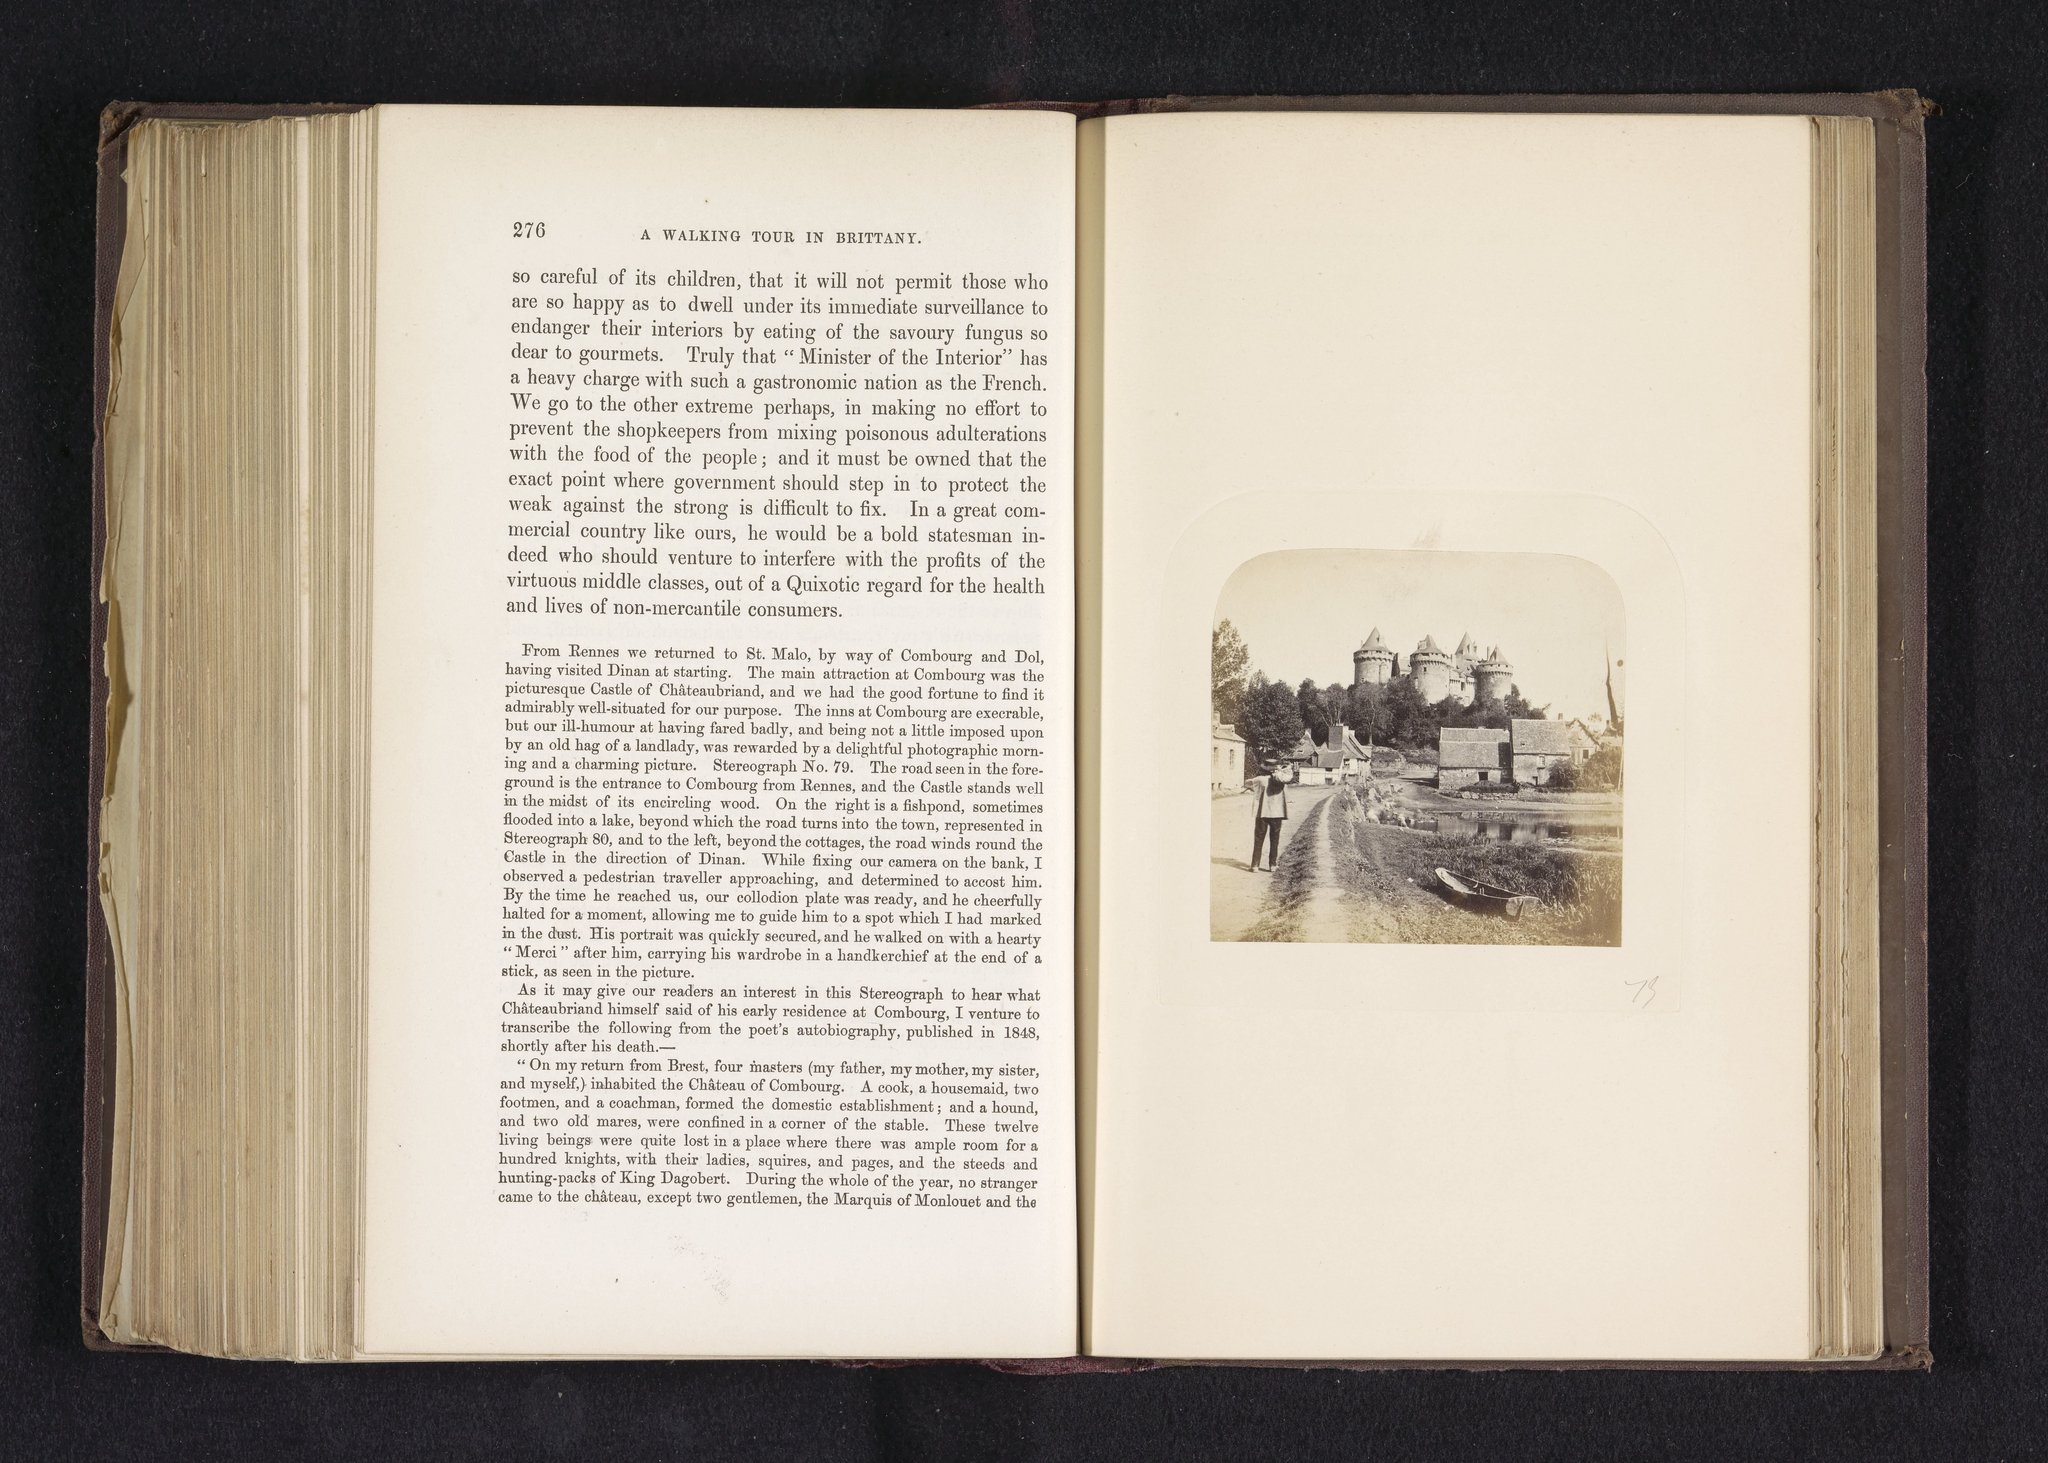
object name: photograph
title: Kasteel van Châteaubriand met meer te Combourg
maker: taylor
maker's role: fotograaf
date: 1850-1859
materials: photographic support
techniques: albumen print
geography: combourg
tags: castle, lake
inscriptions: number: ‘79’